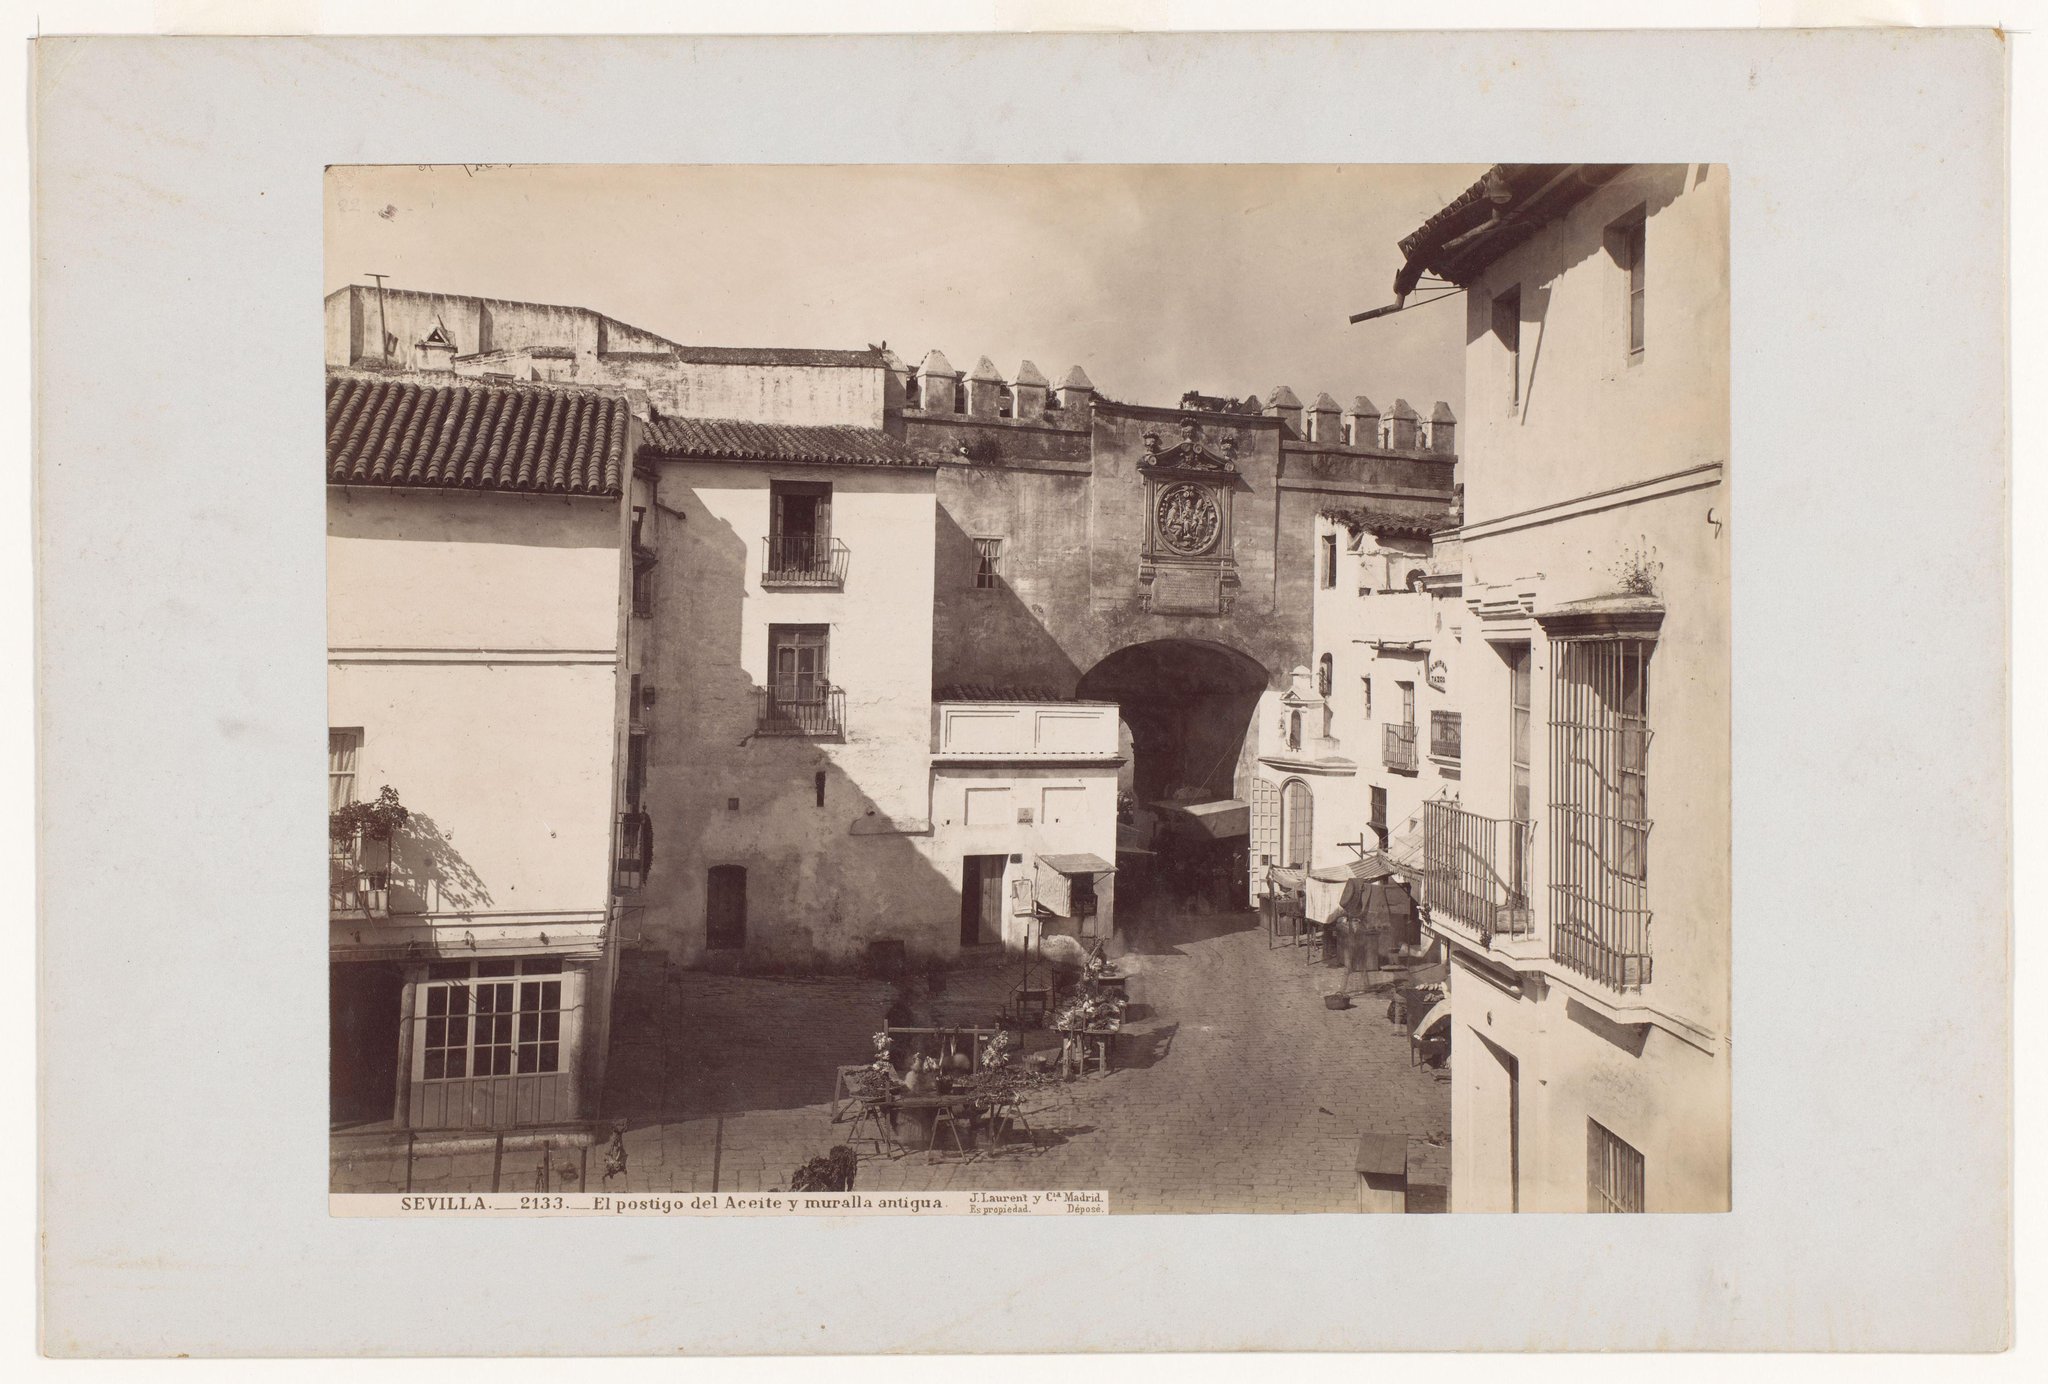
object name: photograph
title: Sevilla-El postigo del aceite y muralla antigua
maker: juan laurent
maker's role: publisher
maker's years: 1816-1896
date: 1857-1880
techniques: albumen print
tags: sevilla